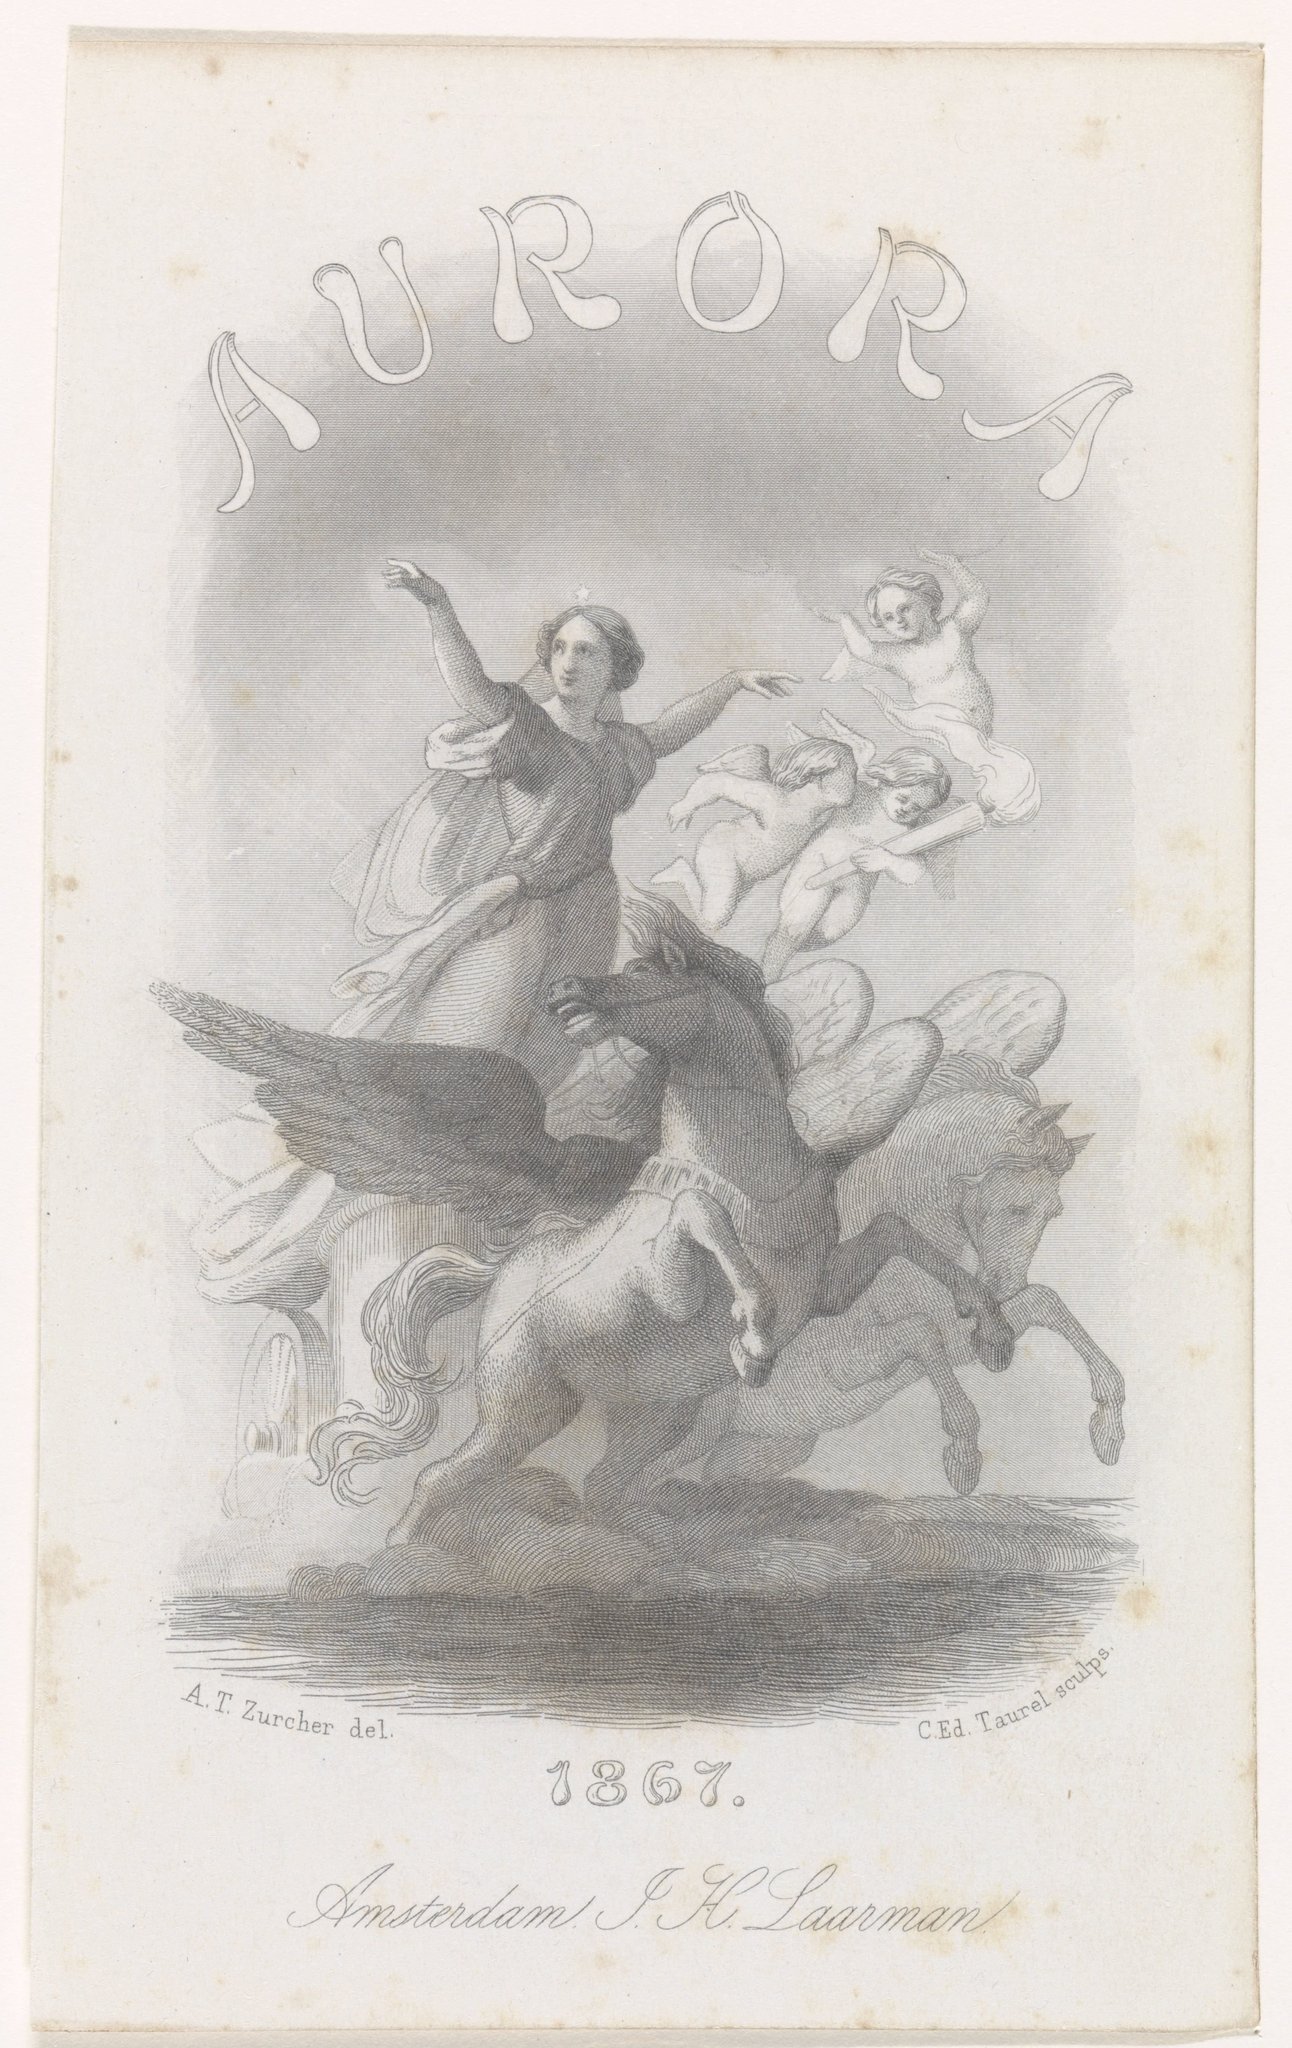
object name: titelblad, titelpagina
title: Aurora op een door twee gevleugelde paarden getrokken wagen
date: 1867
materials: paper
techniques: engraving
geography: amsterdam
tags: personification of the morning, 'aurora'; 'aurora' (ripa), (story of) aurora (eos); 'aurora' (ripa)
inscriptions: collector's mark: Lugt 2228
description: De godin van het ochtendgloren, Aurora, staand op een door twee gevleugelde paarden getrokken wagen. In de lucht drie putti waarvan één een brandende fakkel vasthoudt.